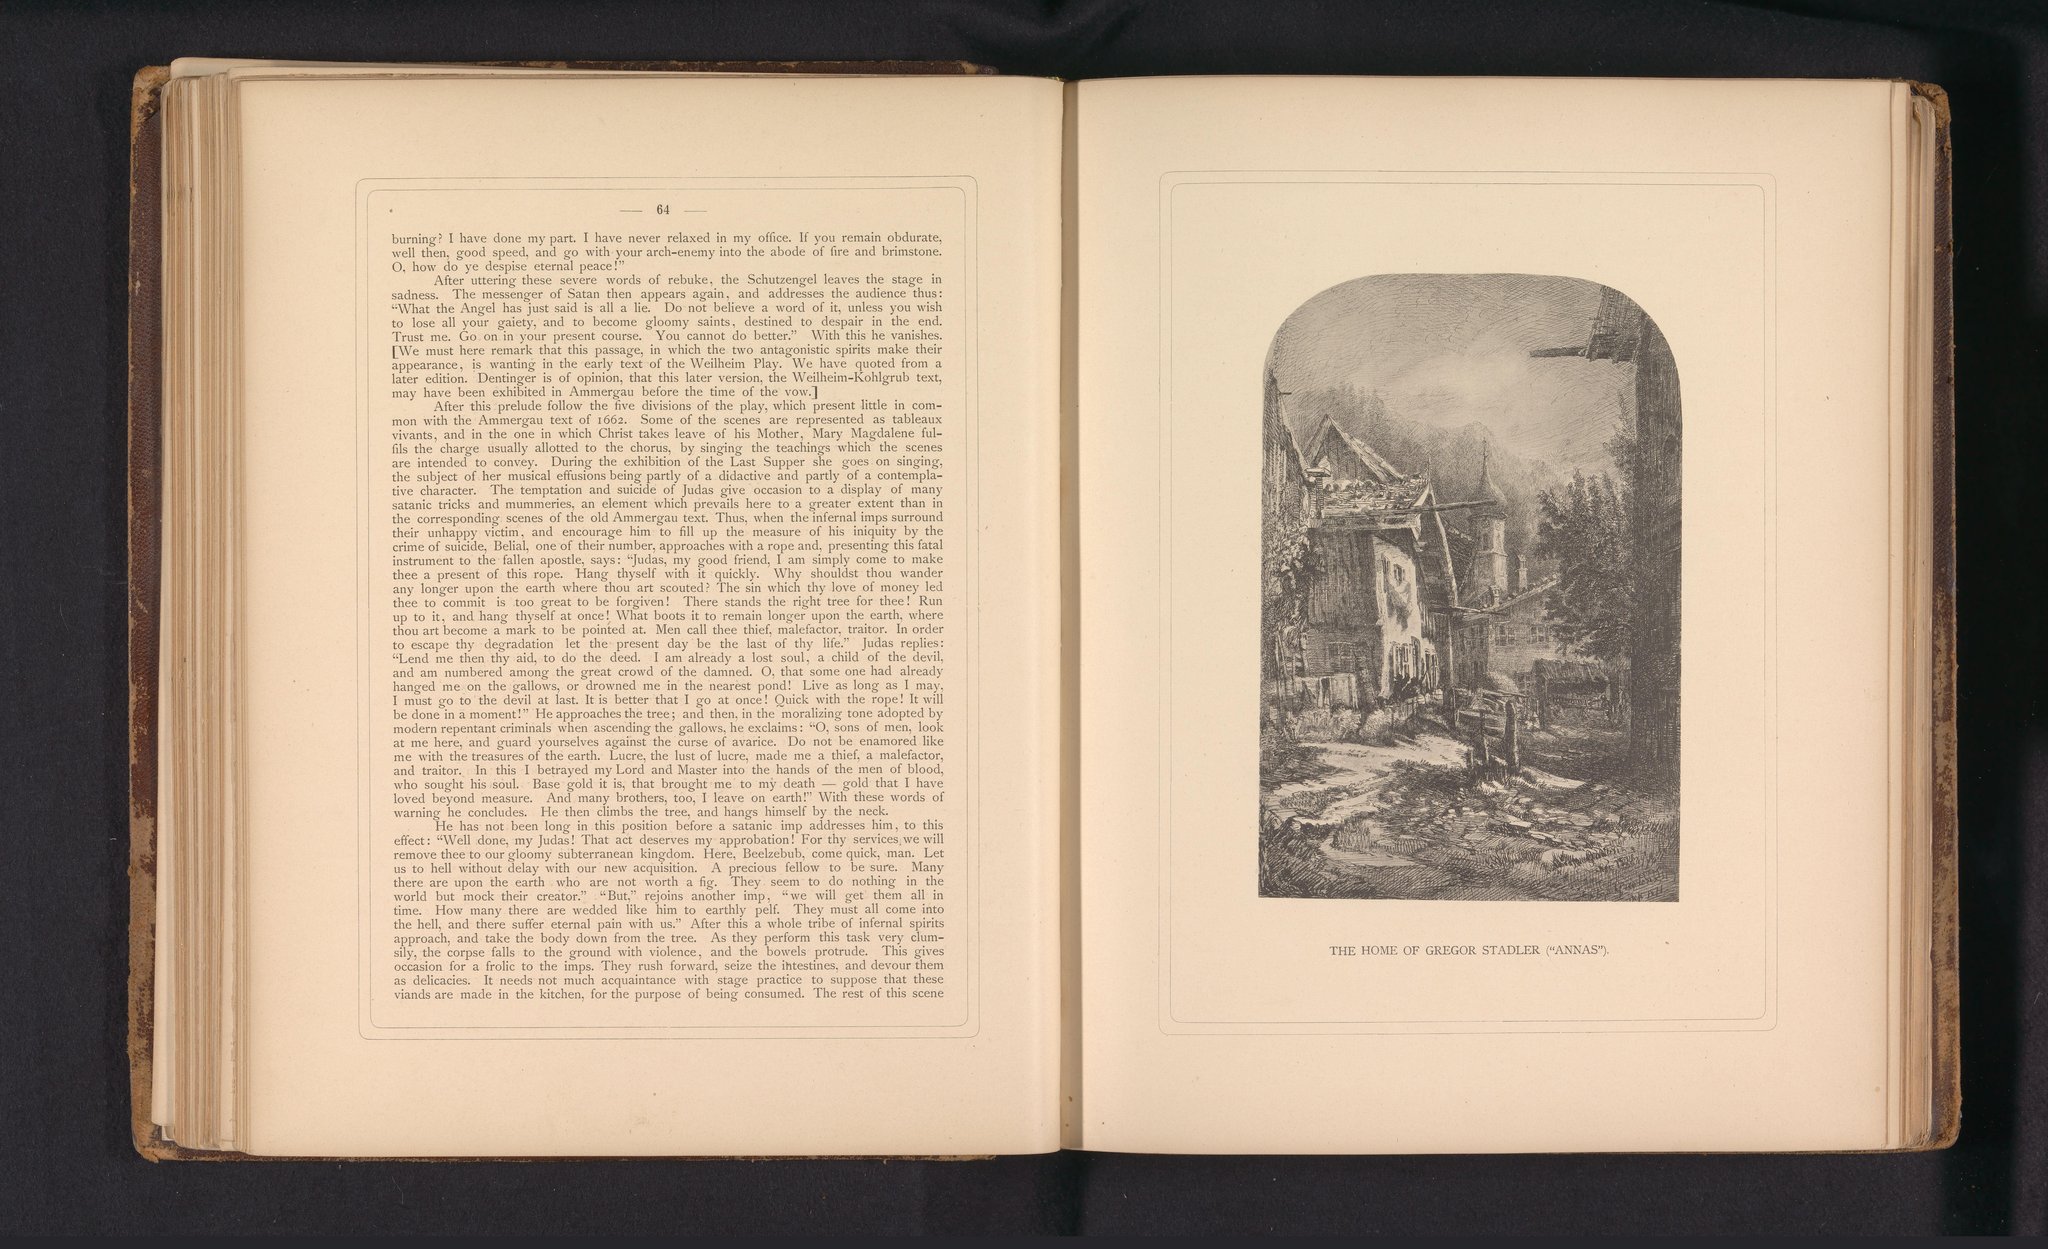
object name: page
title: The home of Gregor Stadler ("Annas")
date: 1871-1873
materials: paper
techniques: photograph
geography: oberammergau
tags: housing, façade (of house or building)